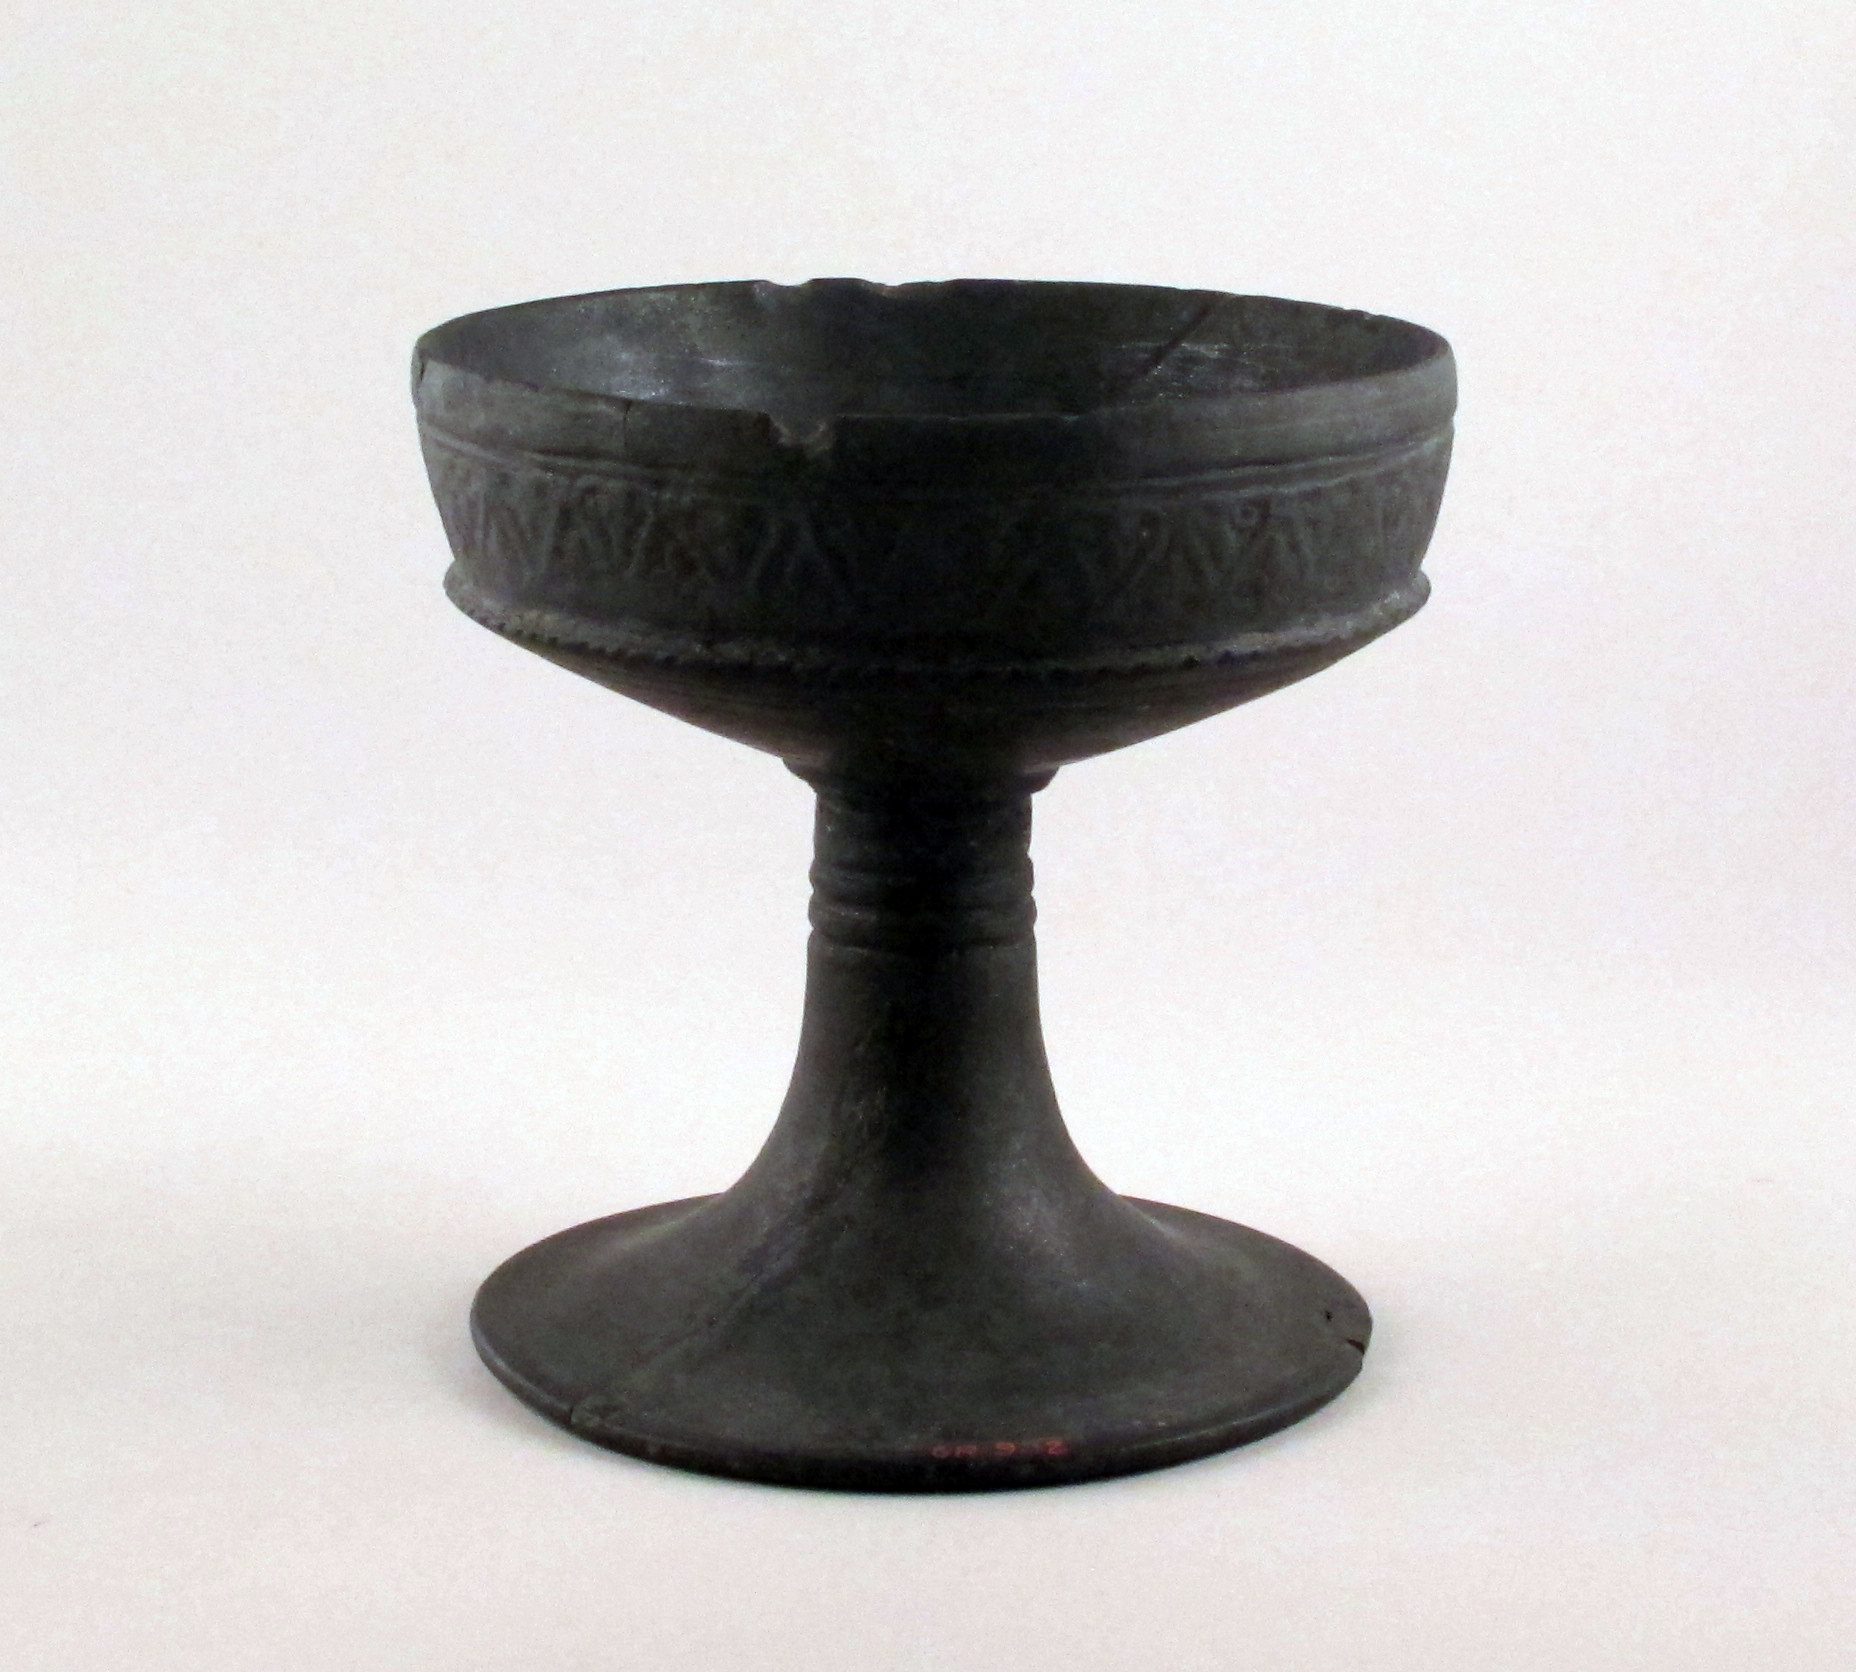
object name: cup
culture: etruscan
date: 600-551 BCE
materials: terracotta